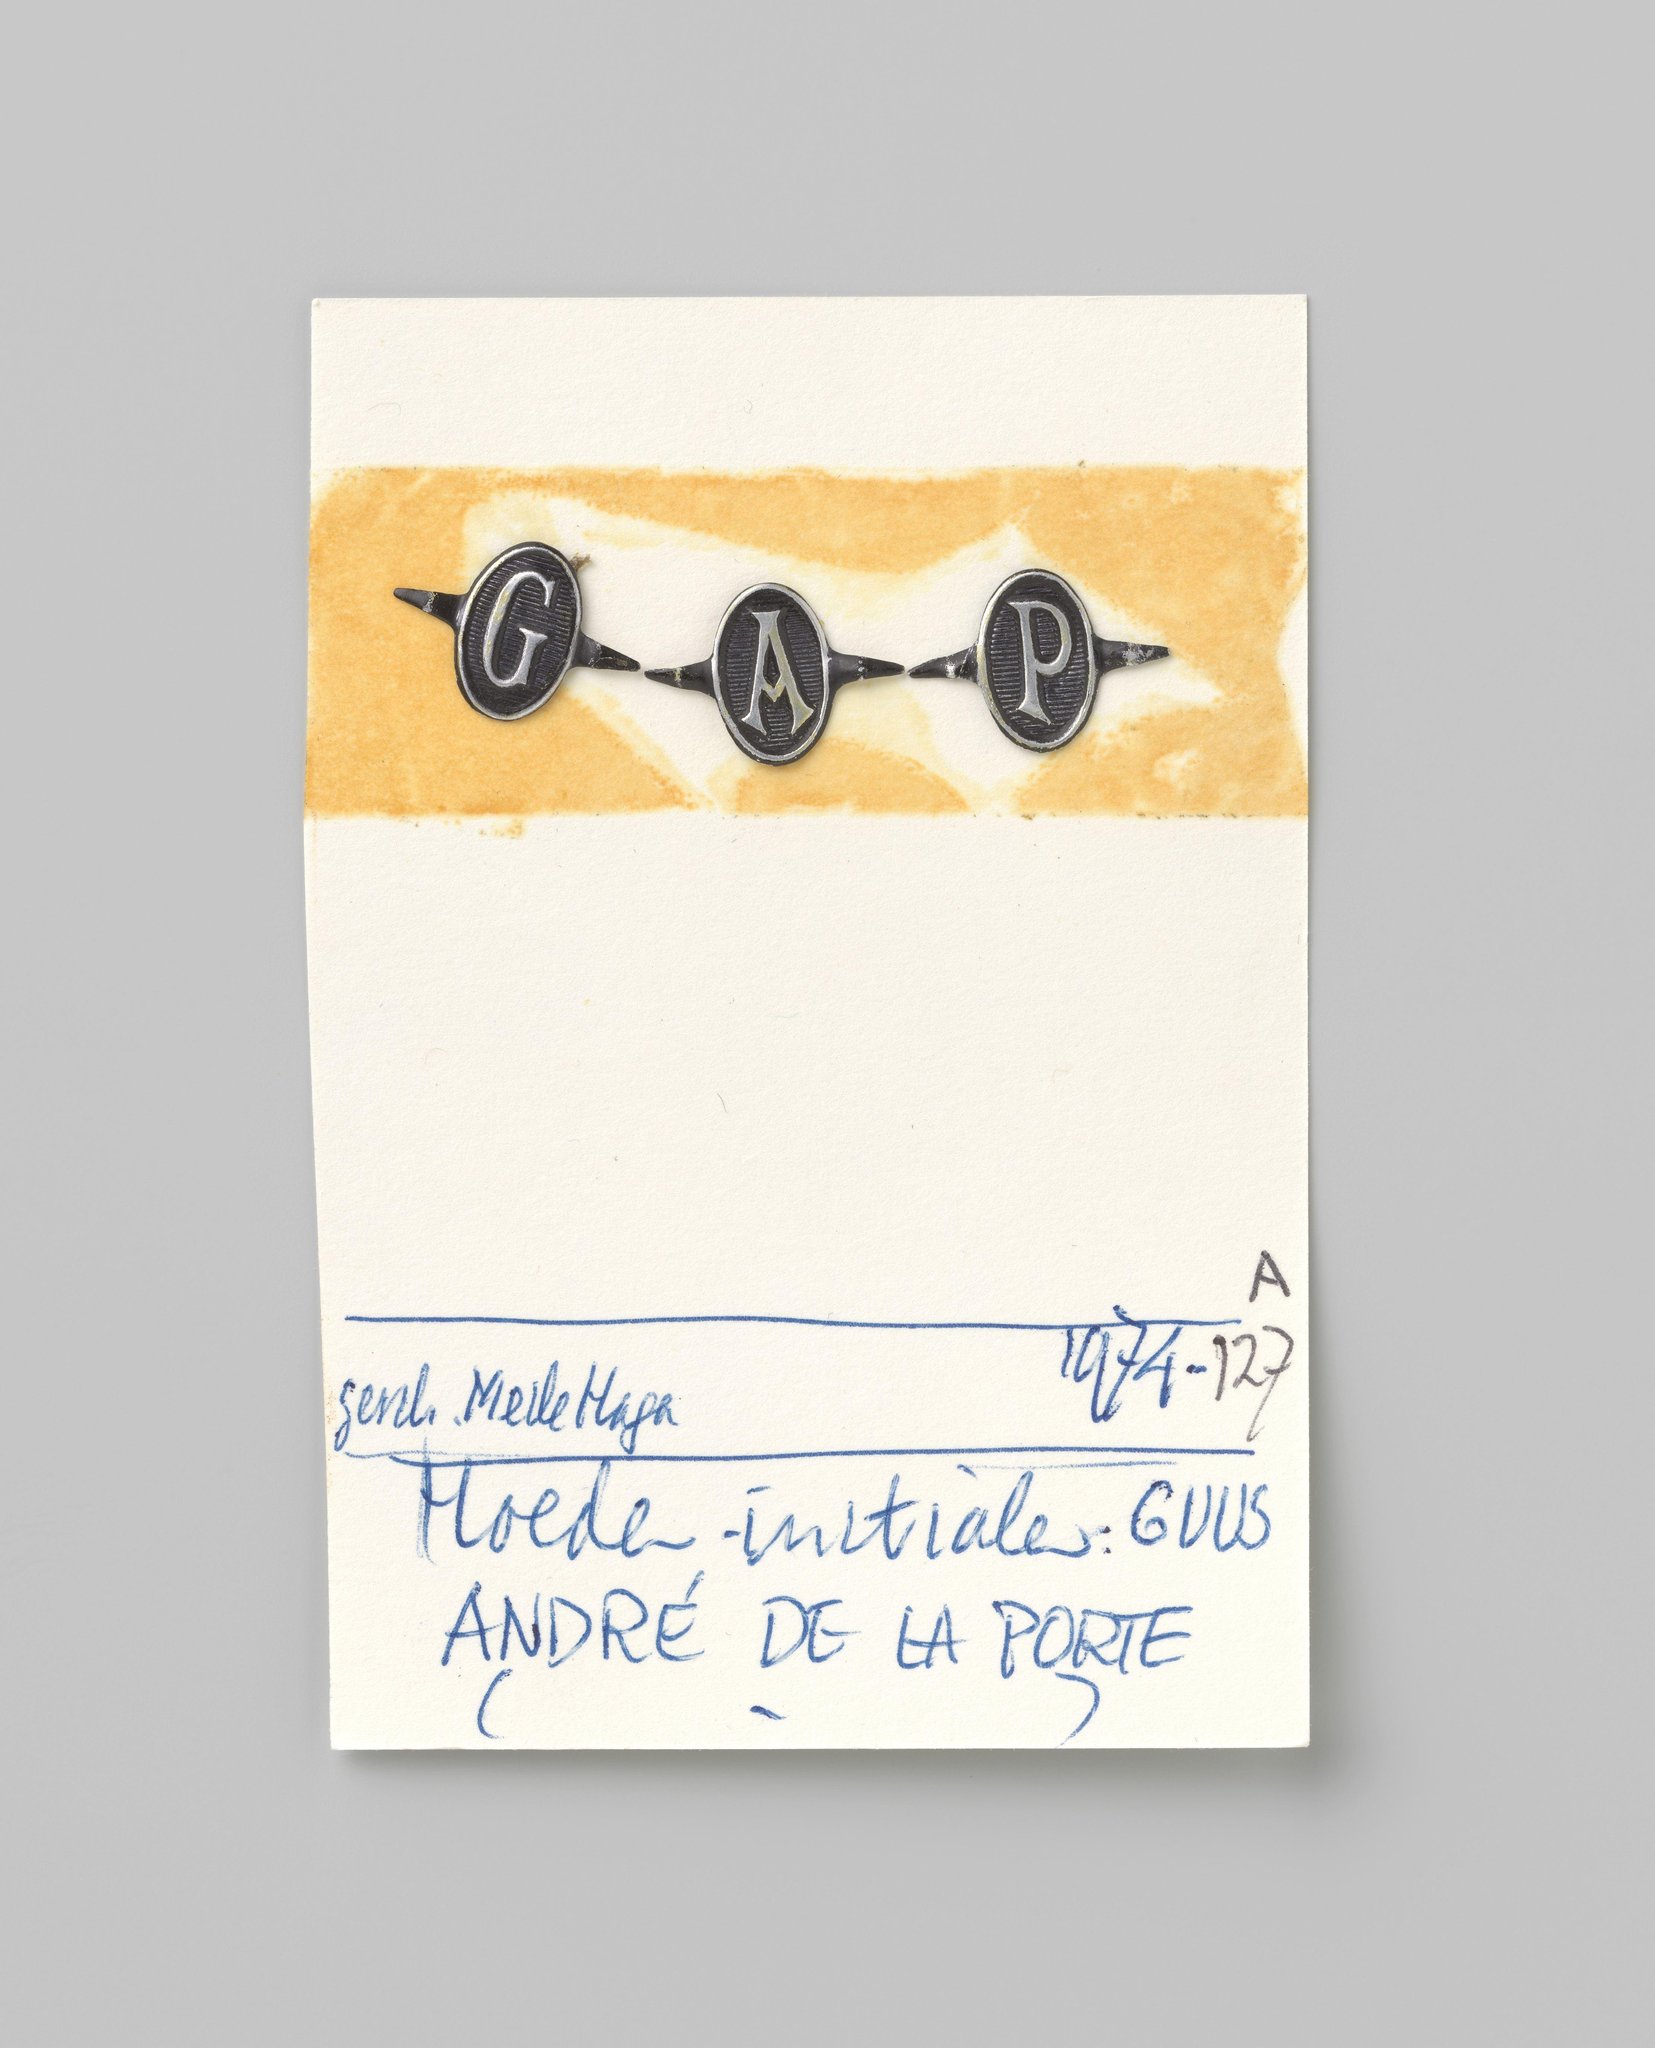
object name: part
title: Letter A om aan hoedenlint te klemmen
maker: Anonymous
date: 1850-1930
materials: metal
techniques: striking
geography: europe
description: De letter hoort bij het drietal letters G A P: Guus André de la Porte.